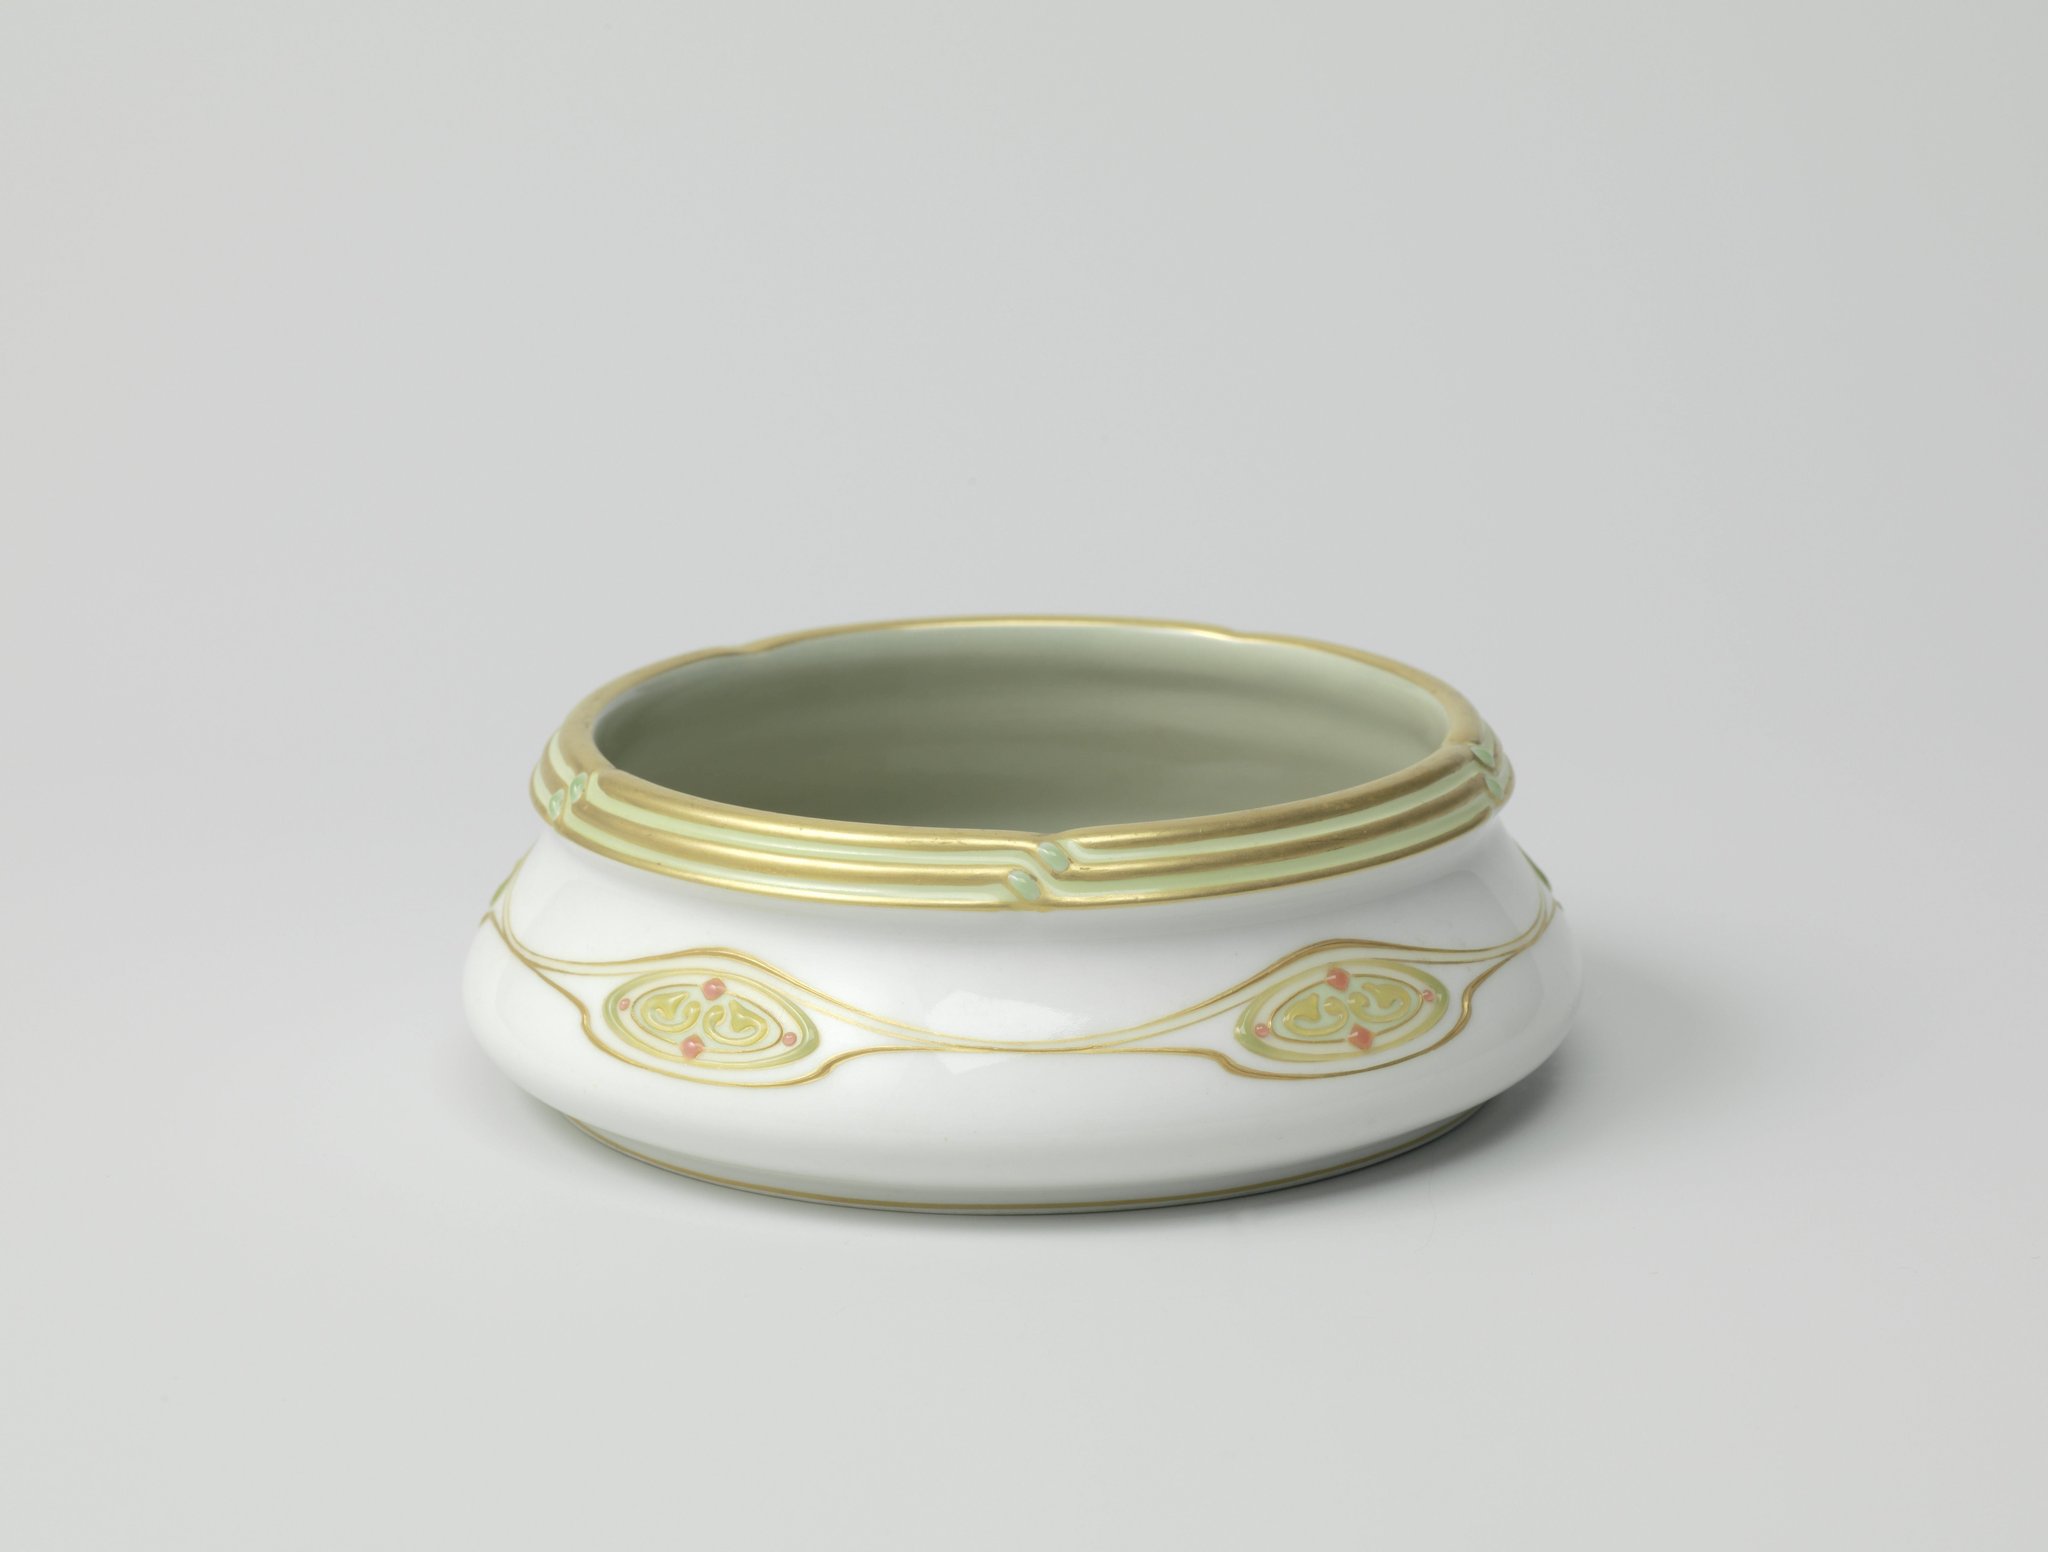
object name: ashtray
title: Ash tray with an ornamental border with medallions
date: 1900-1915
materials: glaze, paint, porcelain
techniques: firing, forming, relief, vitrification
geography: berlin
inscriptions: mark: ‘scepter/ 28 en 43/ rode rijksappel met 'K.P.M'’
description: Asbak van porselein met een laag, gedrukt peervormig lichaam en getrapte rand. Beschilderd op het glazuur in rood, groen en goud. Op de buik een decoratieve band met vijf medaillons met stippen en krulwerk. De rand met gouden en groene banden. De binnenzijde is bedekt met een groen glazuur. Gemerkt op de onderzijde met de scepter, de cijfers 28 en 43 en een rode rijksappel met 'K.P.M'. Art Nouveau.